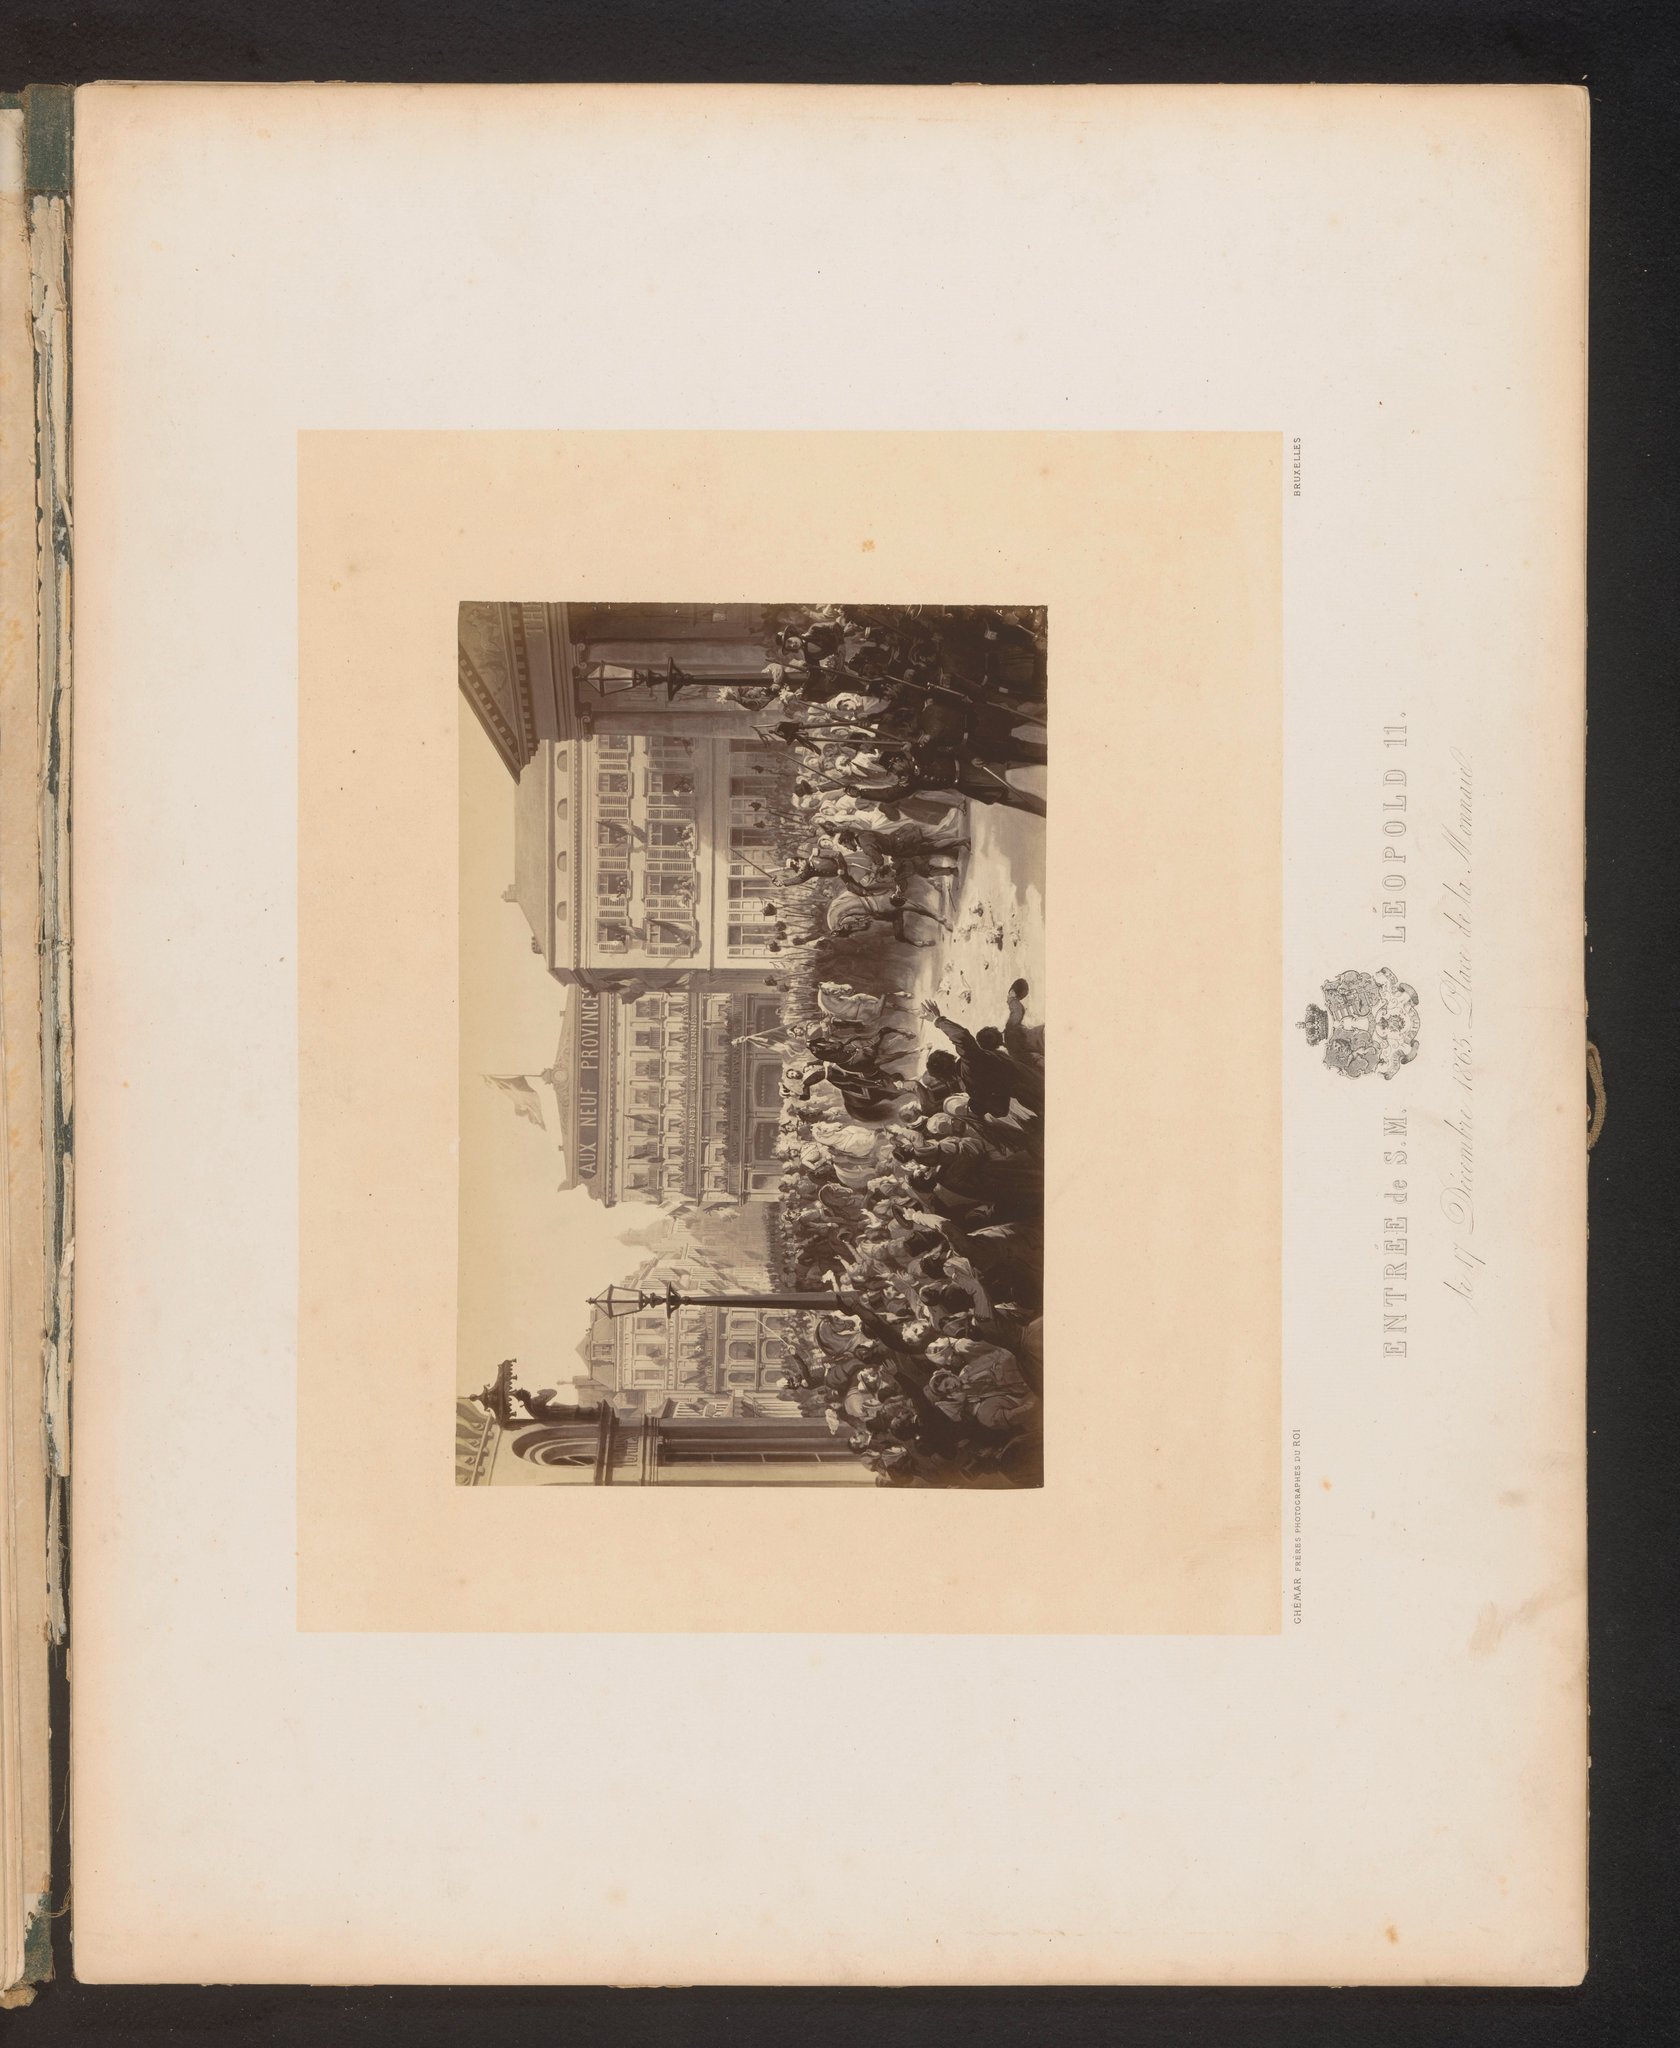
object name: reproduction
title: Fotoreproductie van een ontwerp van de aankomst van Léopold II van België op Place de la Monnaie in Brussel tijdens zijn inhuldiging op 17 december 1865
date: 1861-1866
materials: photographic support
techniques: albumen print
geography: brussels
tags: leopold ii (koning der belgen), ceremonial celebration of installation of a ruler, king, brussels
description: Deze foto maakt deel uit van een omslag met veertien foto's.